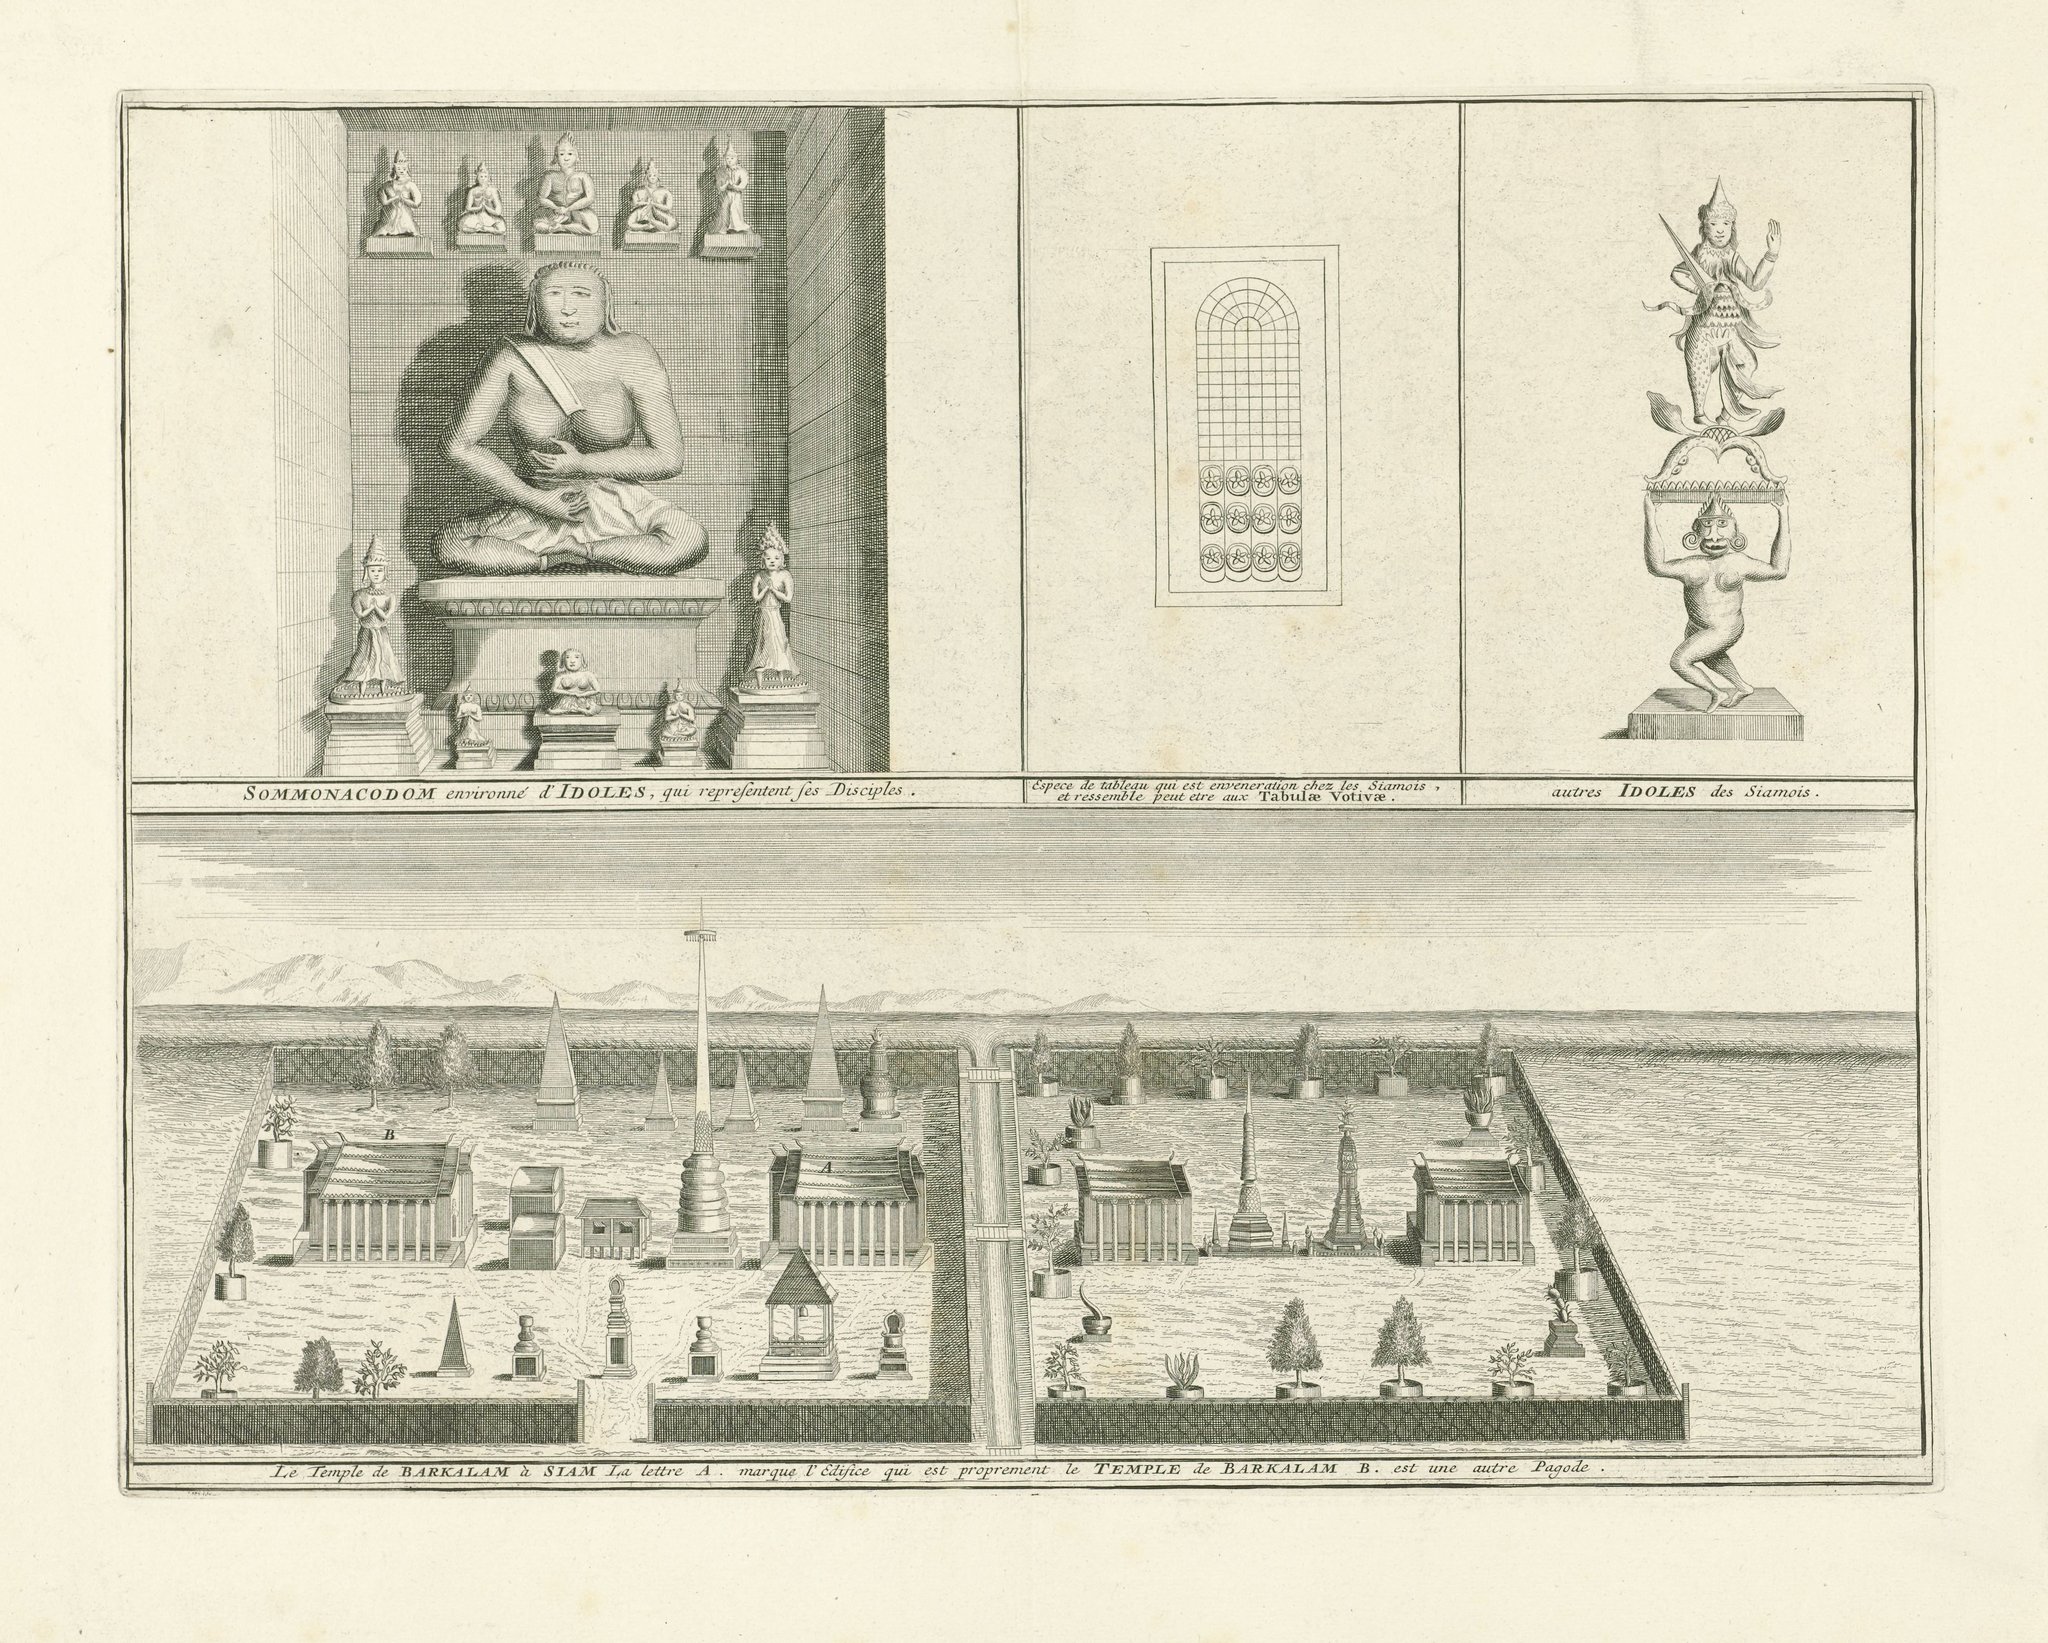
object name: book illustration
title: Representations of Religious Customs in Siam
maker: bernard picart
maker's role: draughtsman, print maker, publisher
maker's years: 1673-1733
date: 1728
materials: paper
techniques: engraving, etching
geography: amsterdam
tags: tribal religions of south-east asia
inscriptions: collector's mark: Lugt 2228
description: Engelbert Kaempfer (1651-1716), a physician with the Dutch East India Company, visited Siam in 1690. The drawings he made of what he saw there served as the basis for this print. Kaempfer called the statue at the upper left ‘a monstrous Bacchus.’ And this is precisely how he depicted it; out of proportion and with large breasts. This is illustrative of the European outlook, wherein the (as yet) unknown was viewed with great interest.